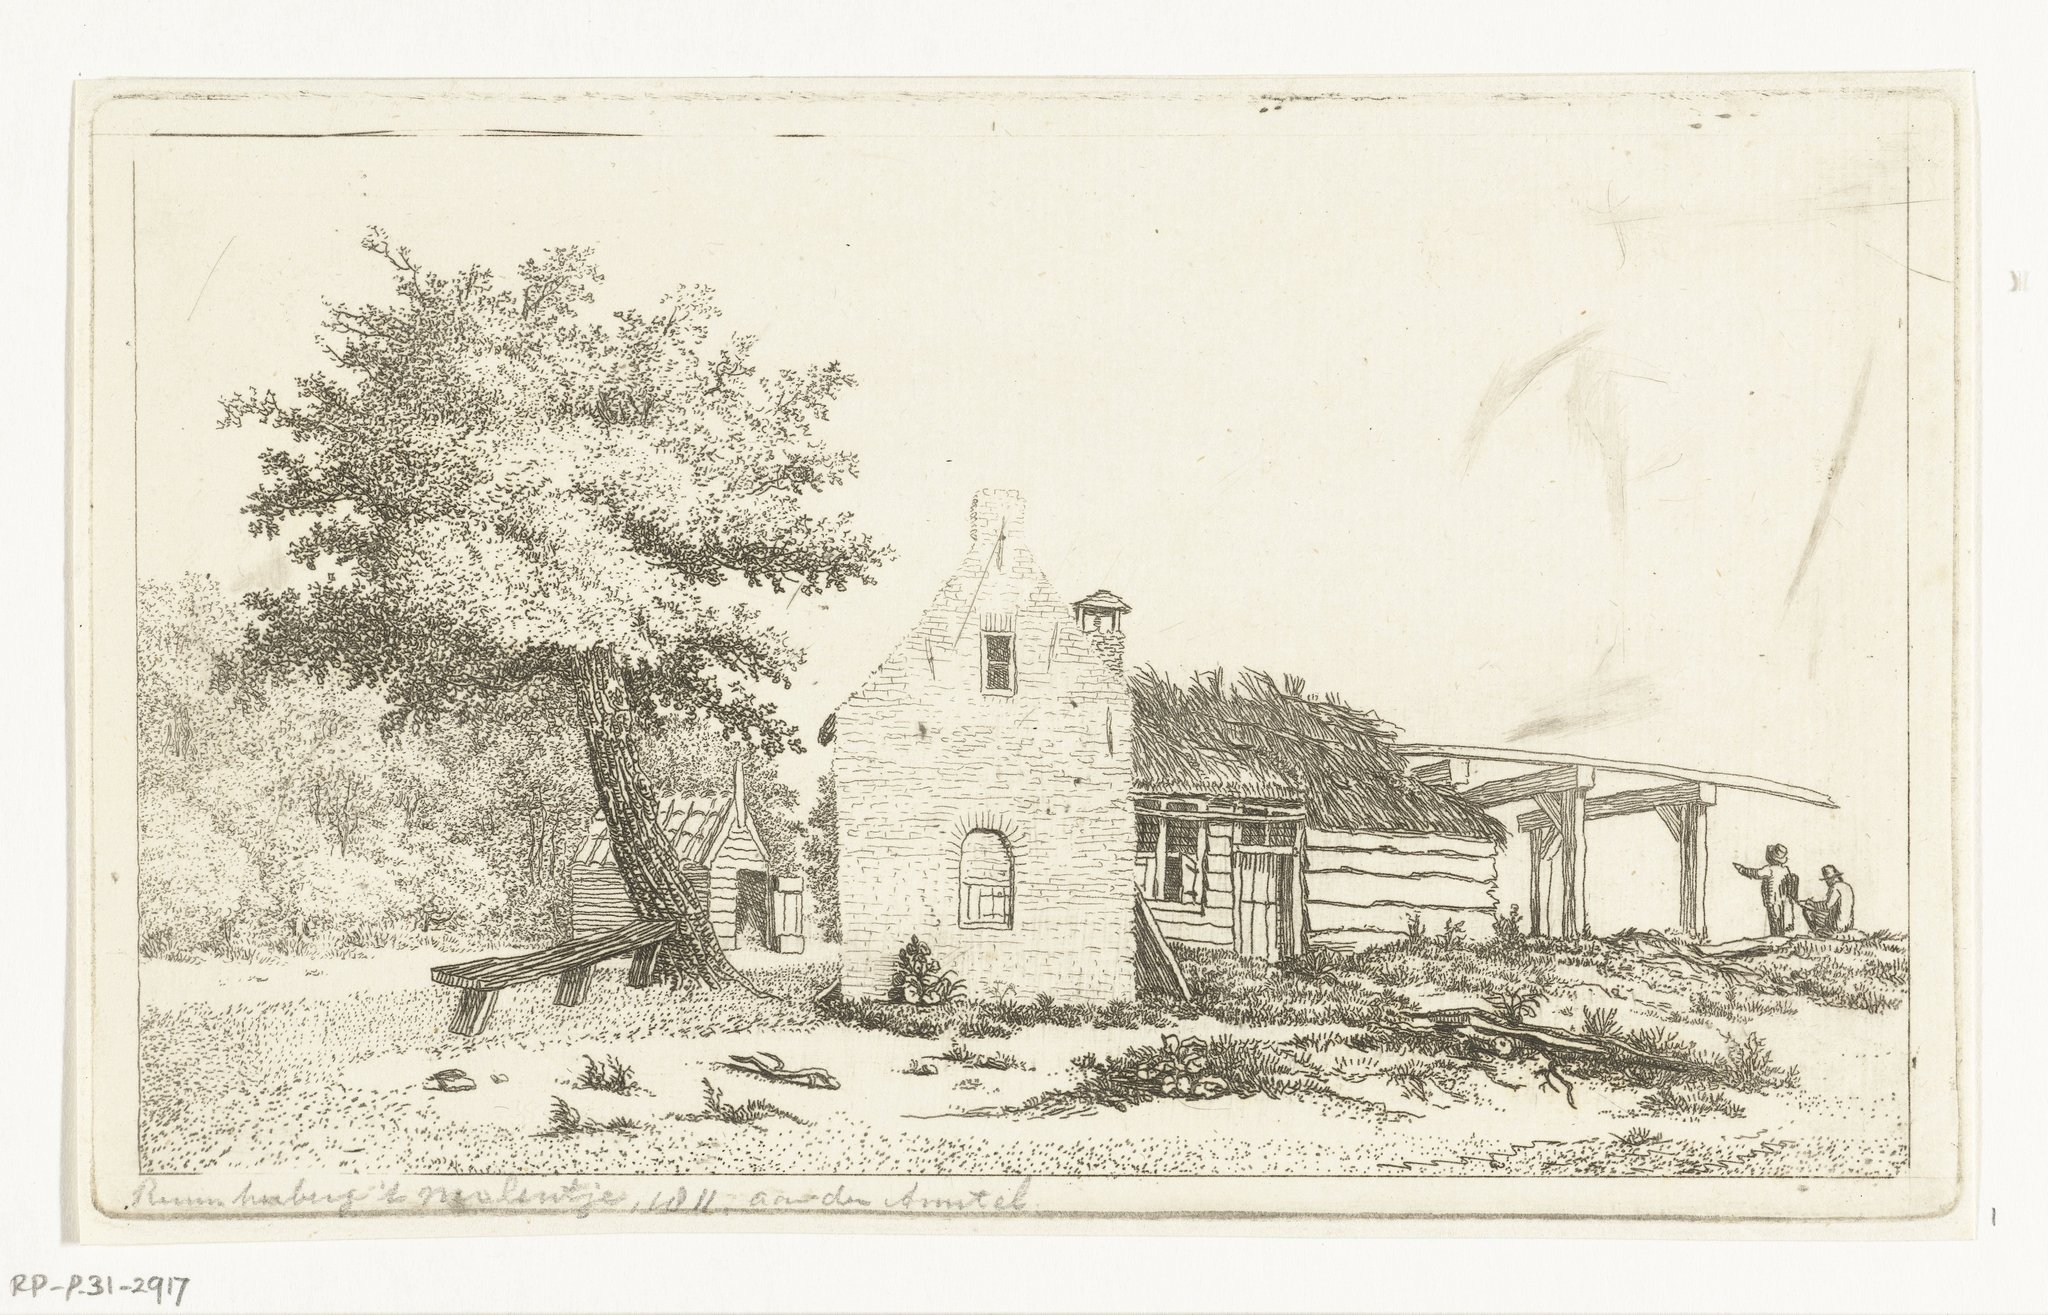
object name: print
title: Ruïne van herberg het Molentje aan de Amstel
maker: anthonie van den bos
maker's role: draughtsman, print maker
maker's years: 1763-1838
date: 1811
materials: paper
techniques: etching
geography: netherlands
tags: hotel, hostelry, inn, ruin of a dwelling, house, castle, etc.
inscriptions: collector's mark: Lugt 2228